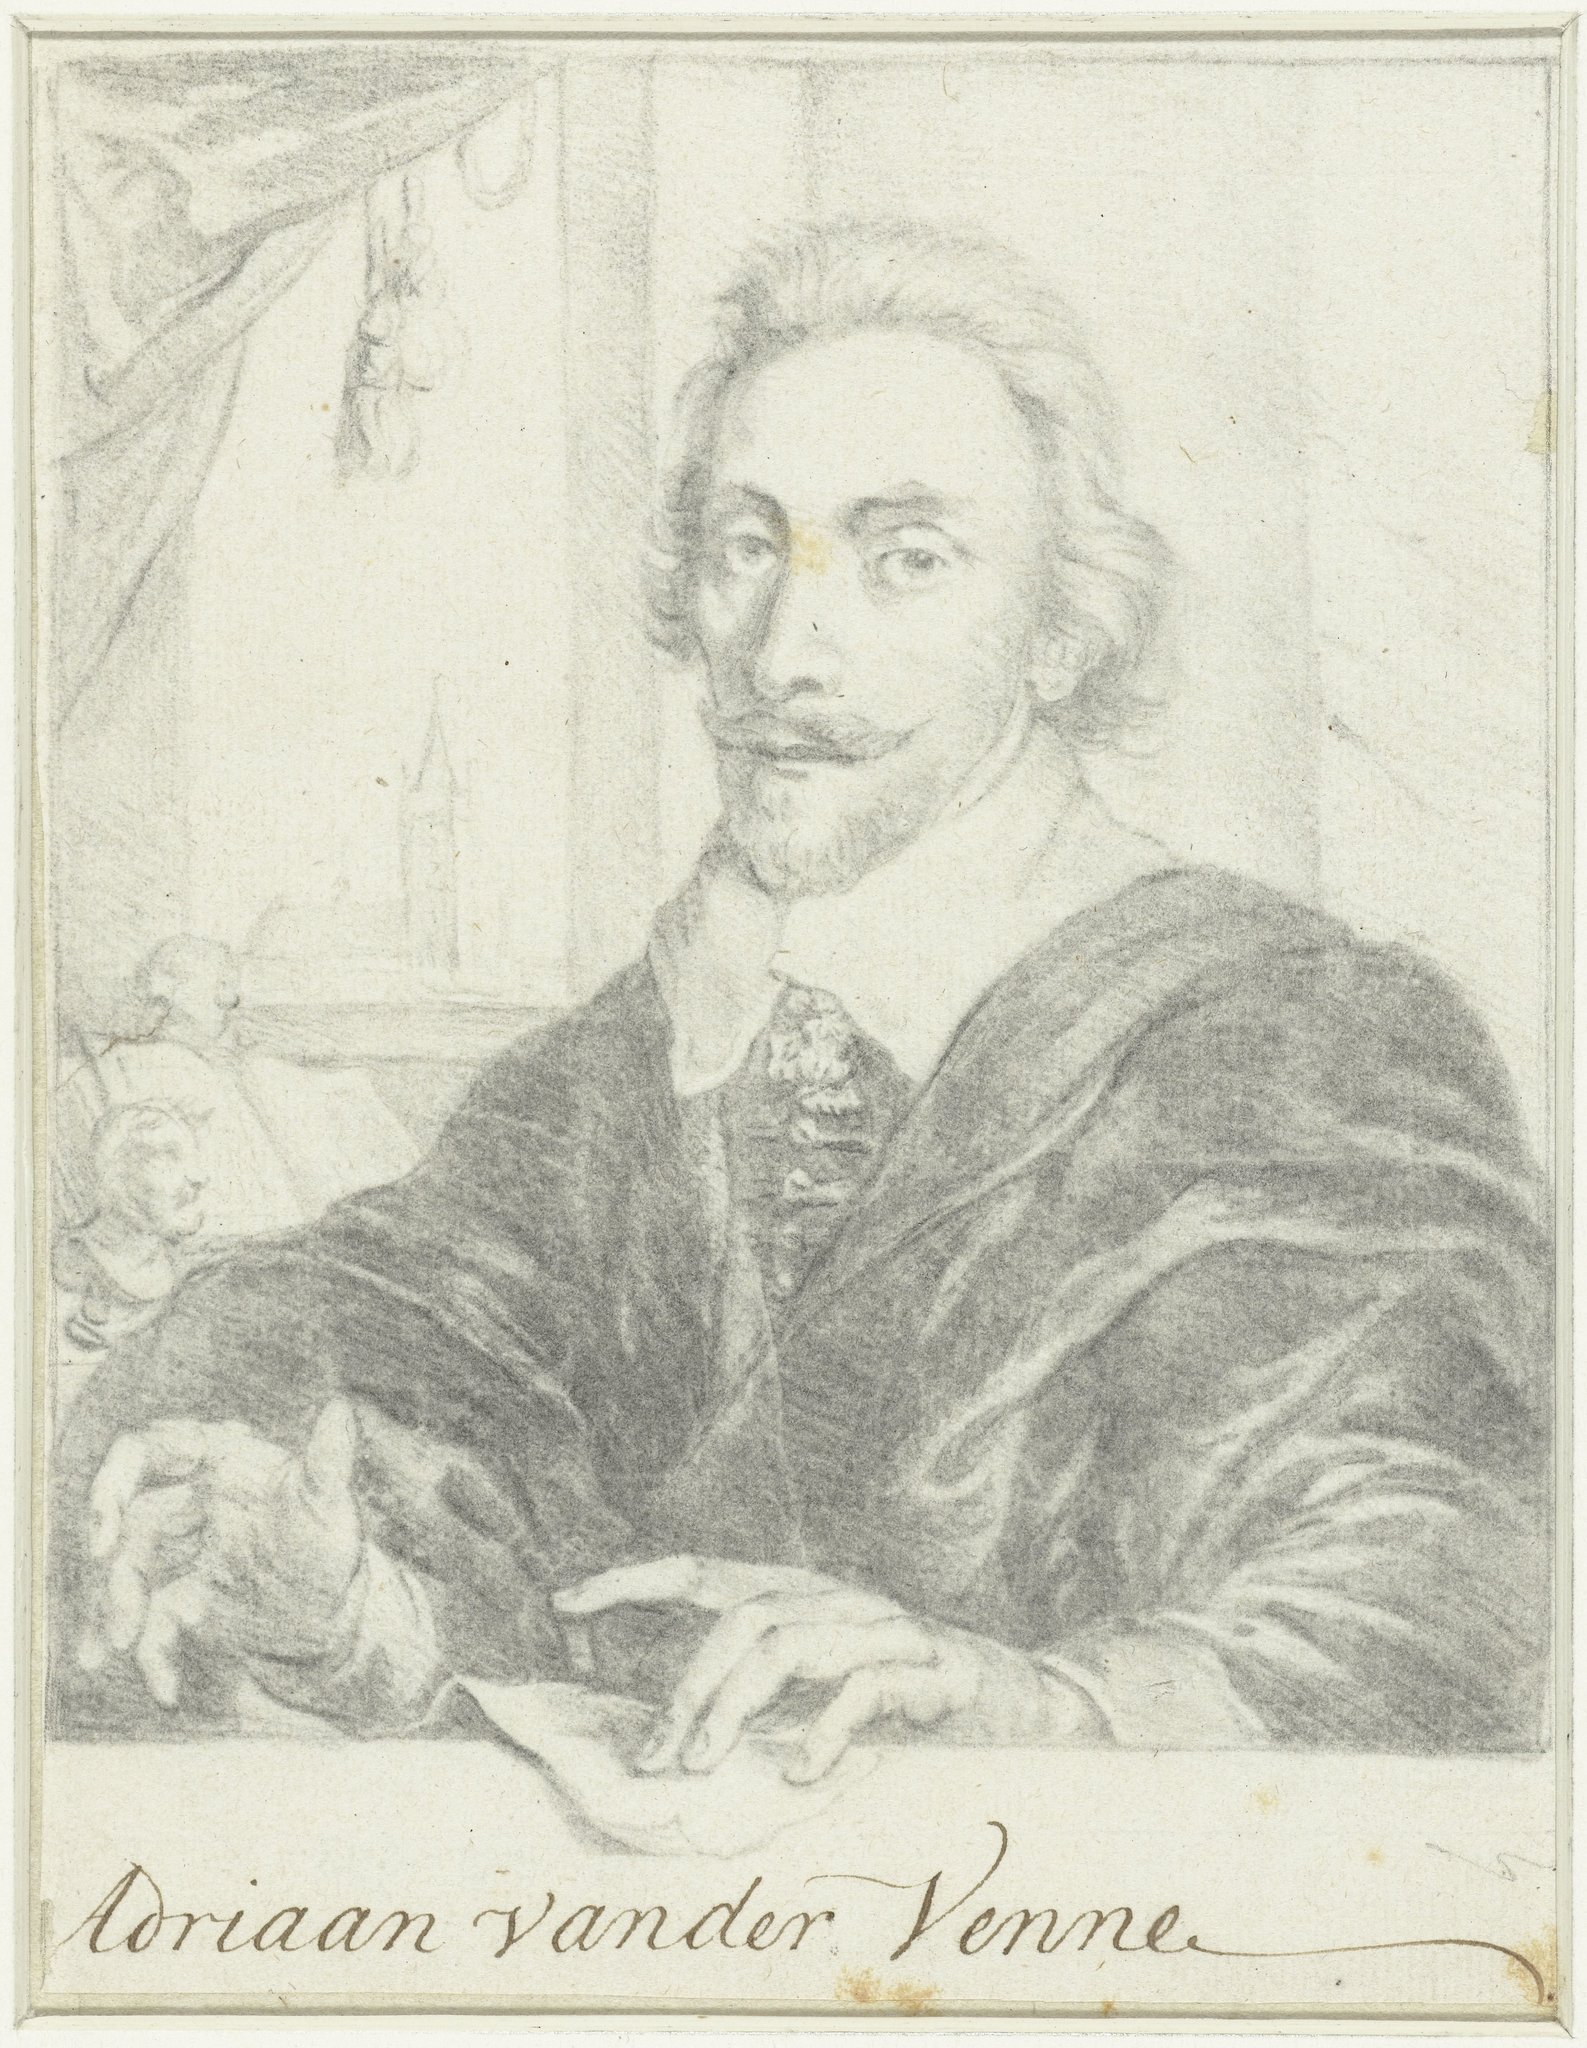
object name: drawing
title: Portret van de schilder Adriaan Pietersz. van de Venne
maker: wenceslaus hollar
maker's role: draughtsman, print maker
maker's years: 1607-1677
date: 1620-1650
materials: chalk, paper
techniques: printmaking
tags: delft, the hague, painter, adriaen pietersz van de venne, historical persons, portrait, self-portrait of painter